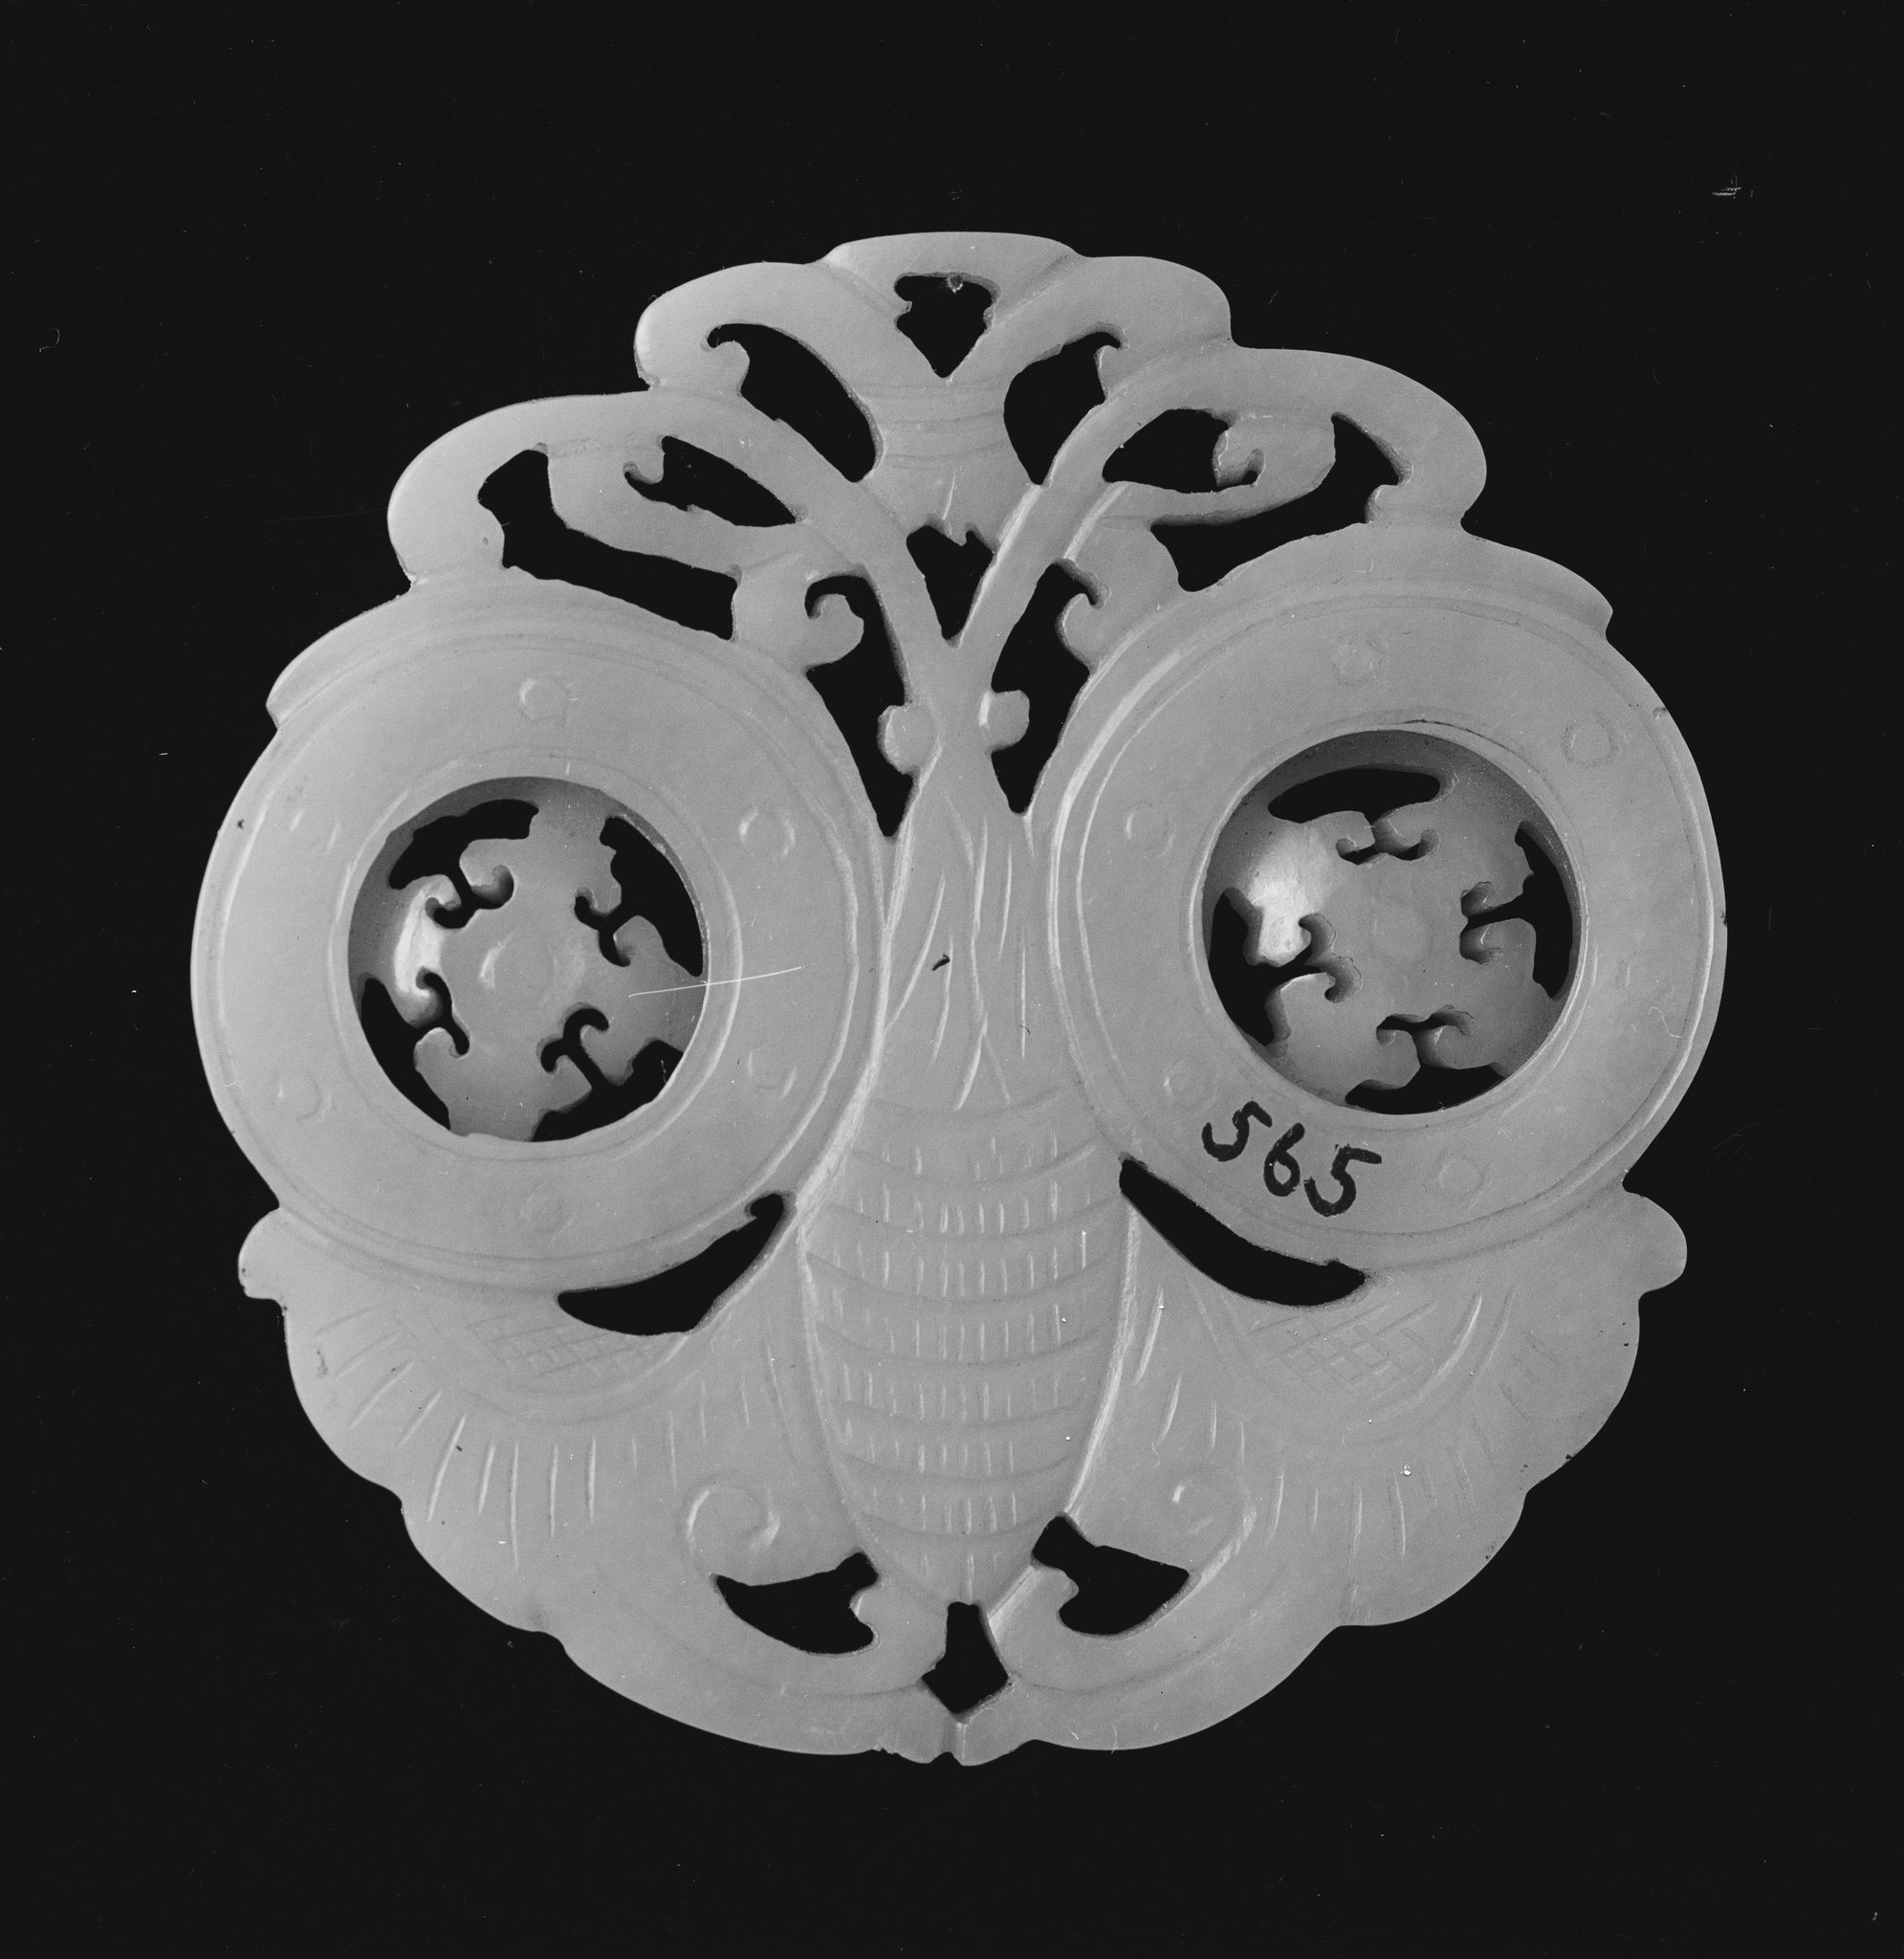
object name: medallion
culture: chinese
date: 1736-1795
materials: jade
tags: insects